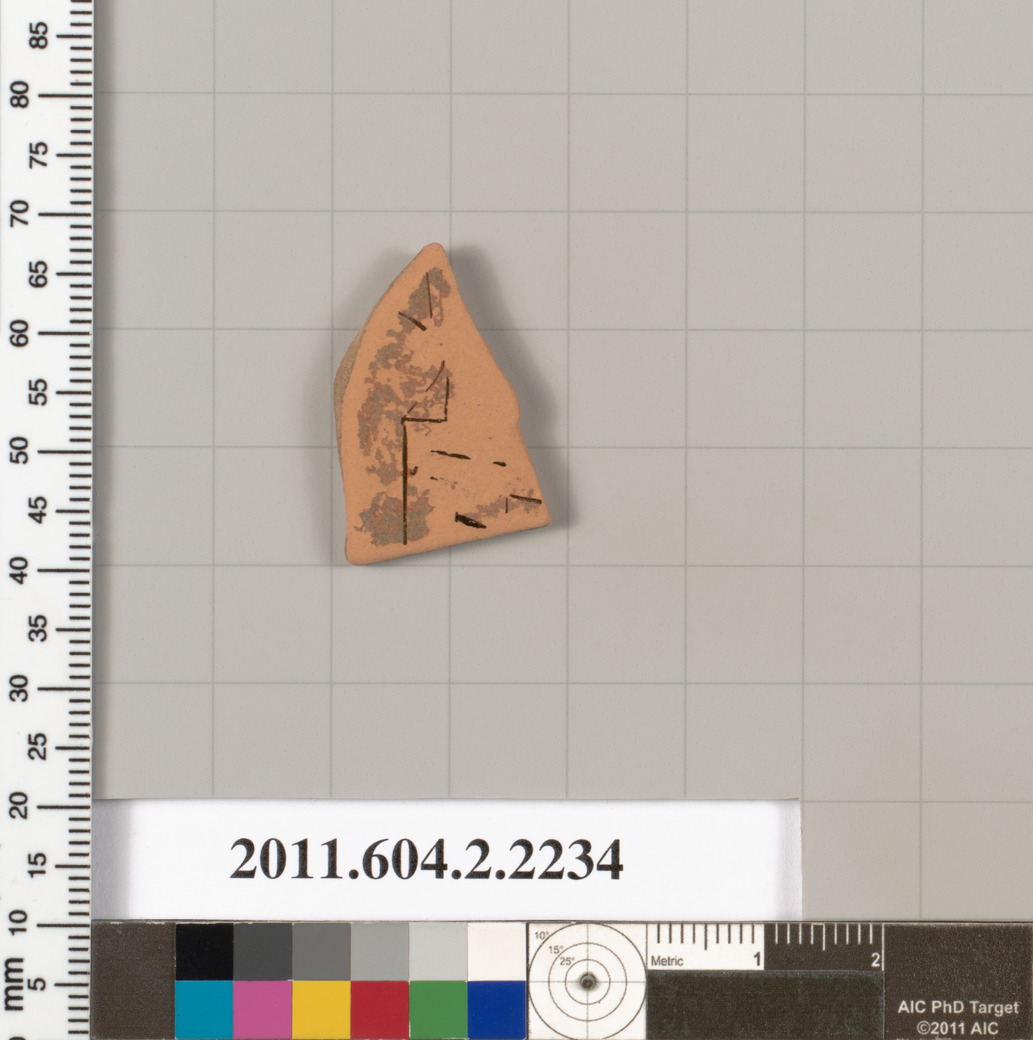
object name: pot fragment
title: Terracotta fragment of a pot; unglazed on the inside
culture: greek, attic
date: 475-451 BCE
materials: terracotta